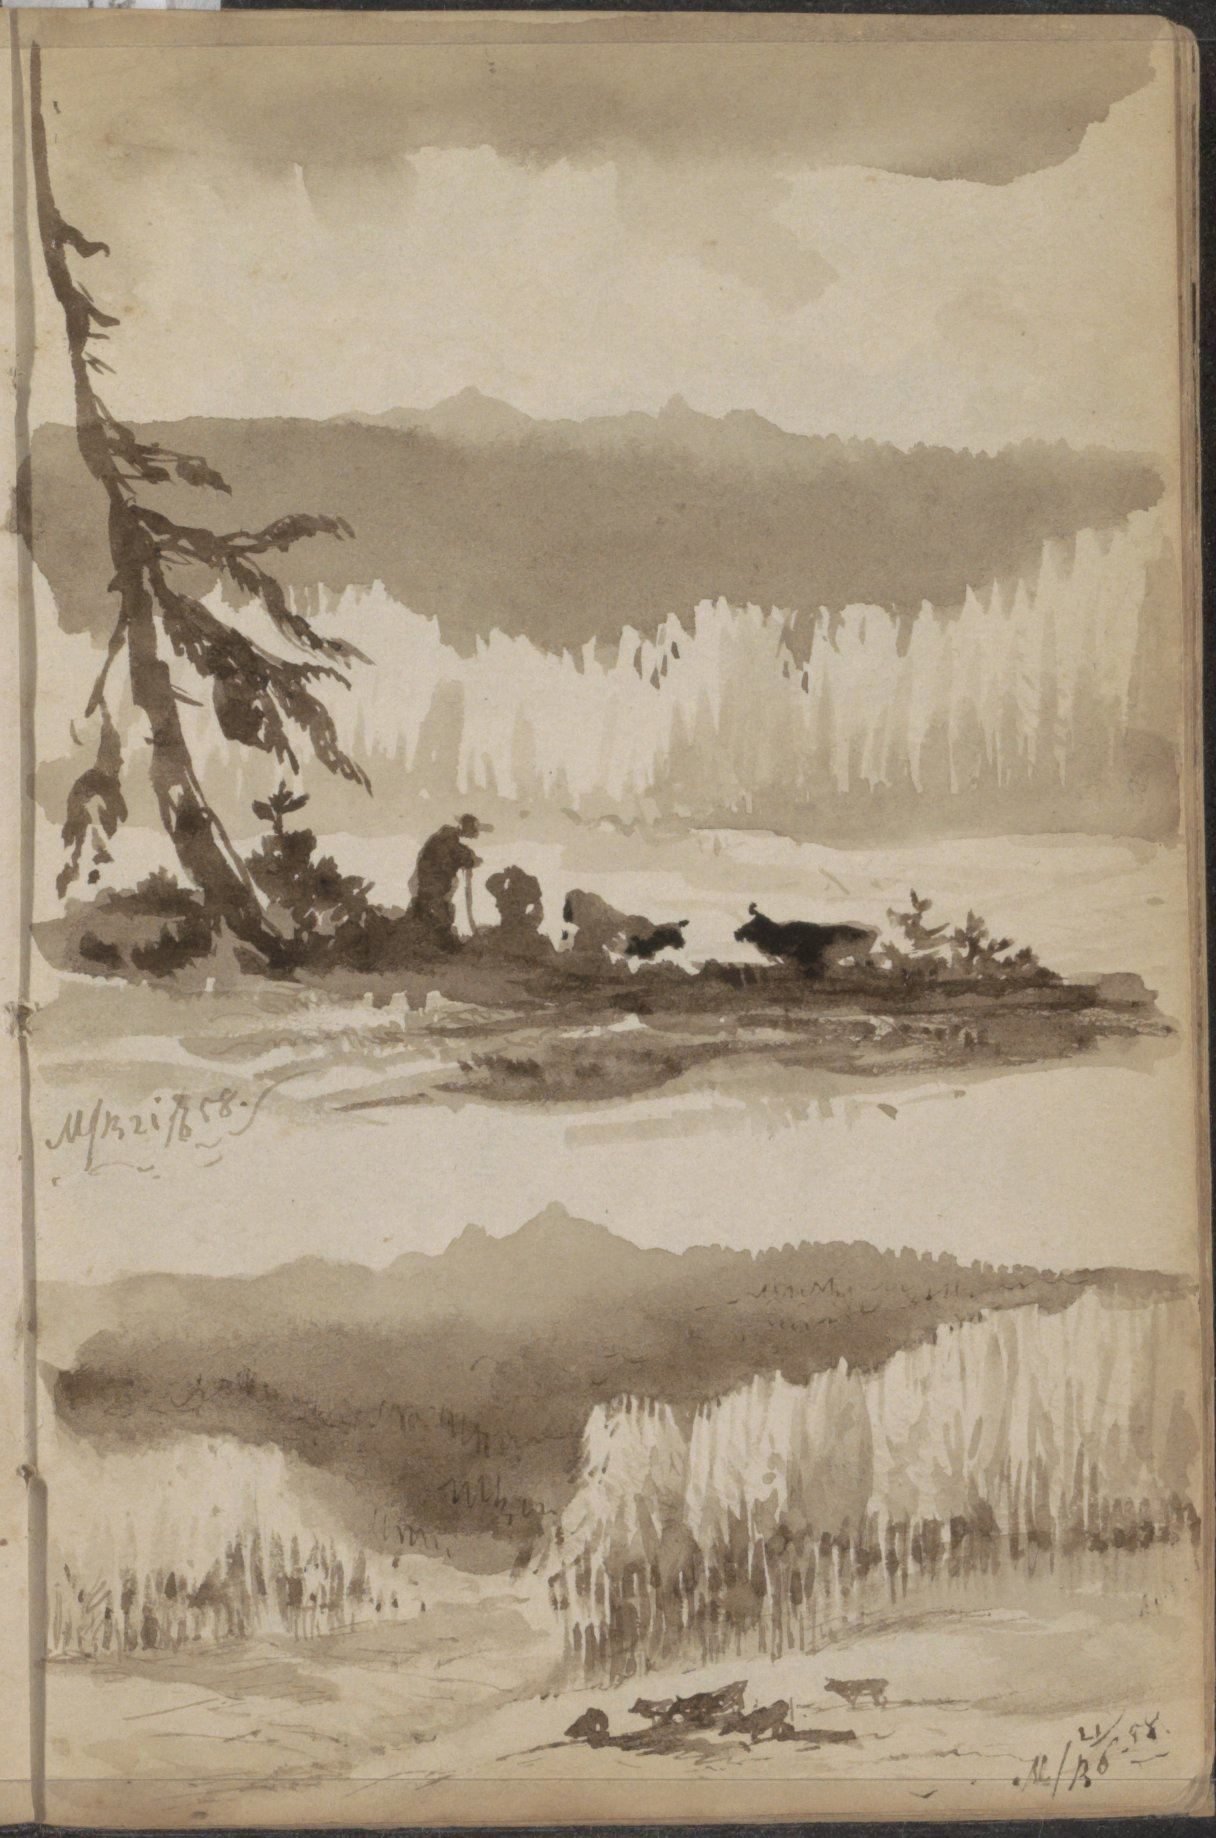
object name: sketchbook leaf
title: Berglandschappen met een herder en vee in Marienbad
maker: johannes tavenraat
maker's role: draughtsman, painter, print maker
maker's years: 1809-1881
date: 1806-1858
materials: ink, paper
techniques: brush, pen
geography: marienbad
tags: herding, herdsman, herdswoman, shepherd, shepherdess, cowherd, etc., cattle, mountains, marienbad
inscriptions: date and inscription: ‘M/B 21/6 58./ 21/6 58/ M/B’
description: Blad 24 recto uit een schetsboek met 44 bladen.